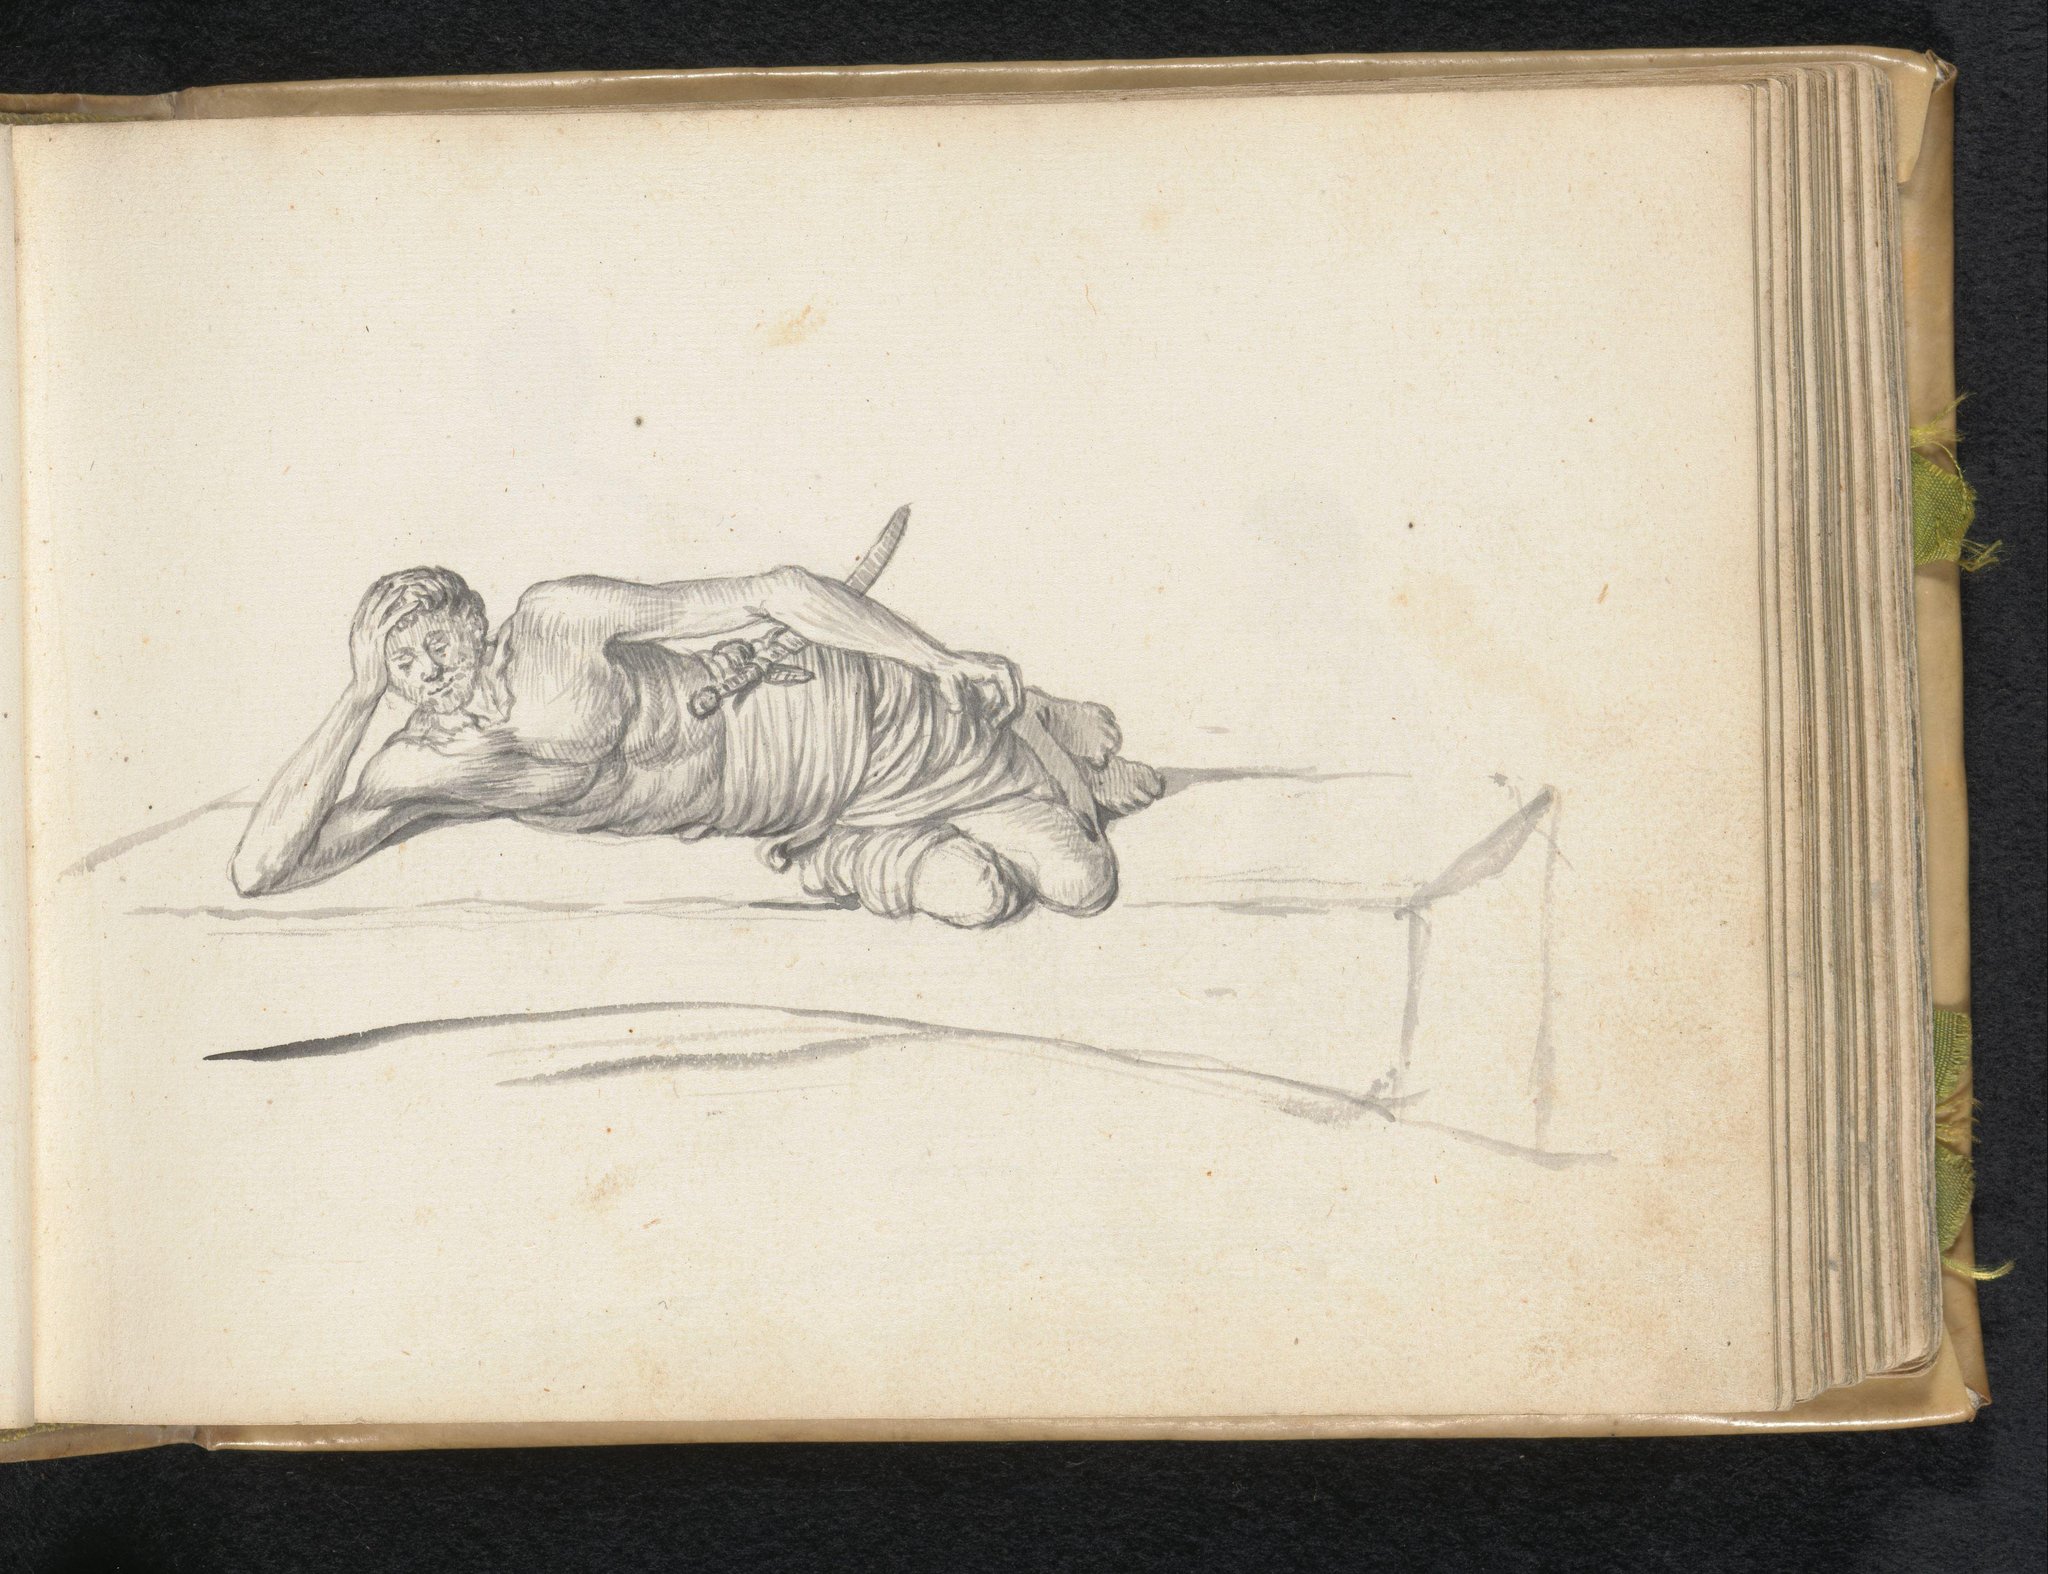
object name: sketchbook leaf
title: A Sinhalese soldier having a lie-down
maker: esaias boursse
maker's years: 1631-1672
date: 1662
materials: ink, paper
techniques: brush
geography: sri lanka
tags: asiatic races and peoples (srilankans), asiatic races and peoples (with name), skirt (dhoti), 41d232(...) skirt (lungi), hacing and thrusting weapons (with name), the soldier; the soldier's life, sri lanka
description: Buiten, op een stenen bank of stoep ligt een man op zijn rechterzij met opgetrokken knieën. Het op Singalese wijze omwonden heupkleed (veshti, lungi) is tot boven de knieën opgeschort. Daarboven draagt hij een brede tailleband. Een kort zwaard (kastane) hangt op de linkerheup. Het draagkoord is niet te zien tussen de plooien. Hij heeft geen muts; wel dik kort haar en een kort baardje. De man is een Singalese huursoldaat (lascorijn), nu in dienst van de Nederlanders. Hij hoort tot de kaste der Goviya. Blad 5 uit een schetsboek met 117 bladen.